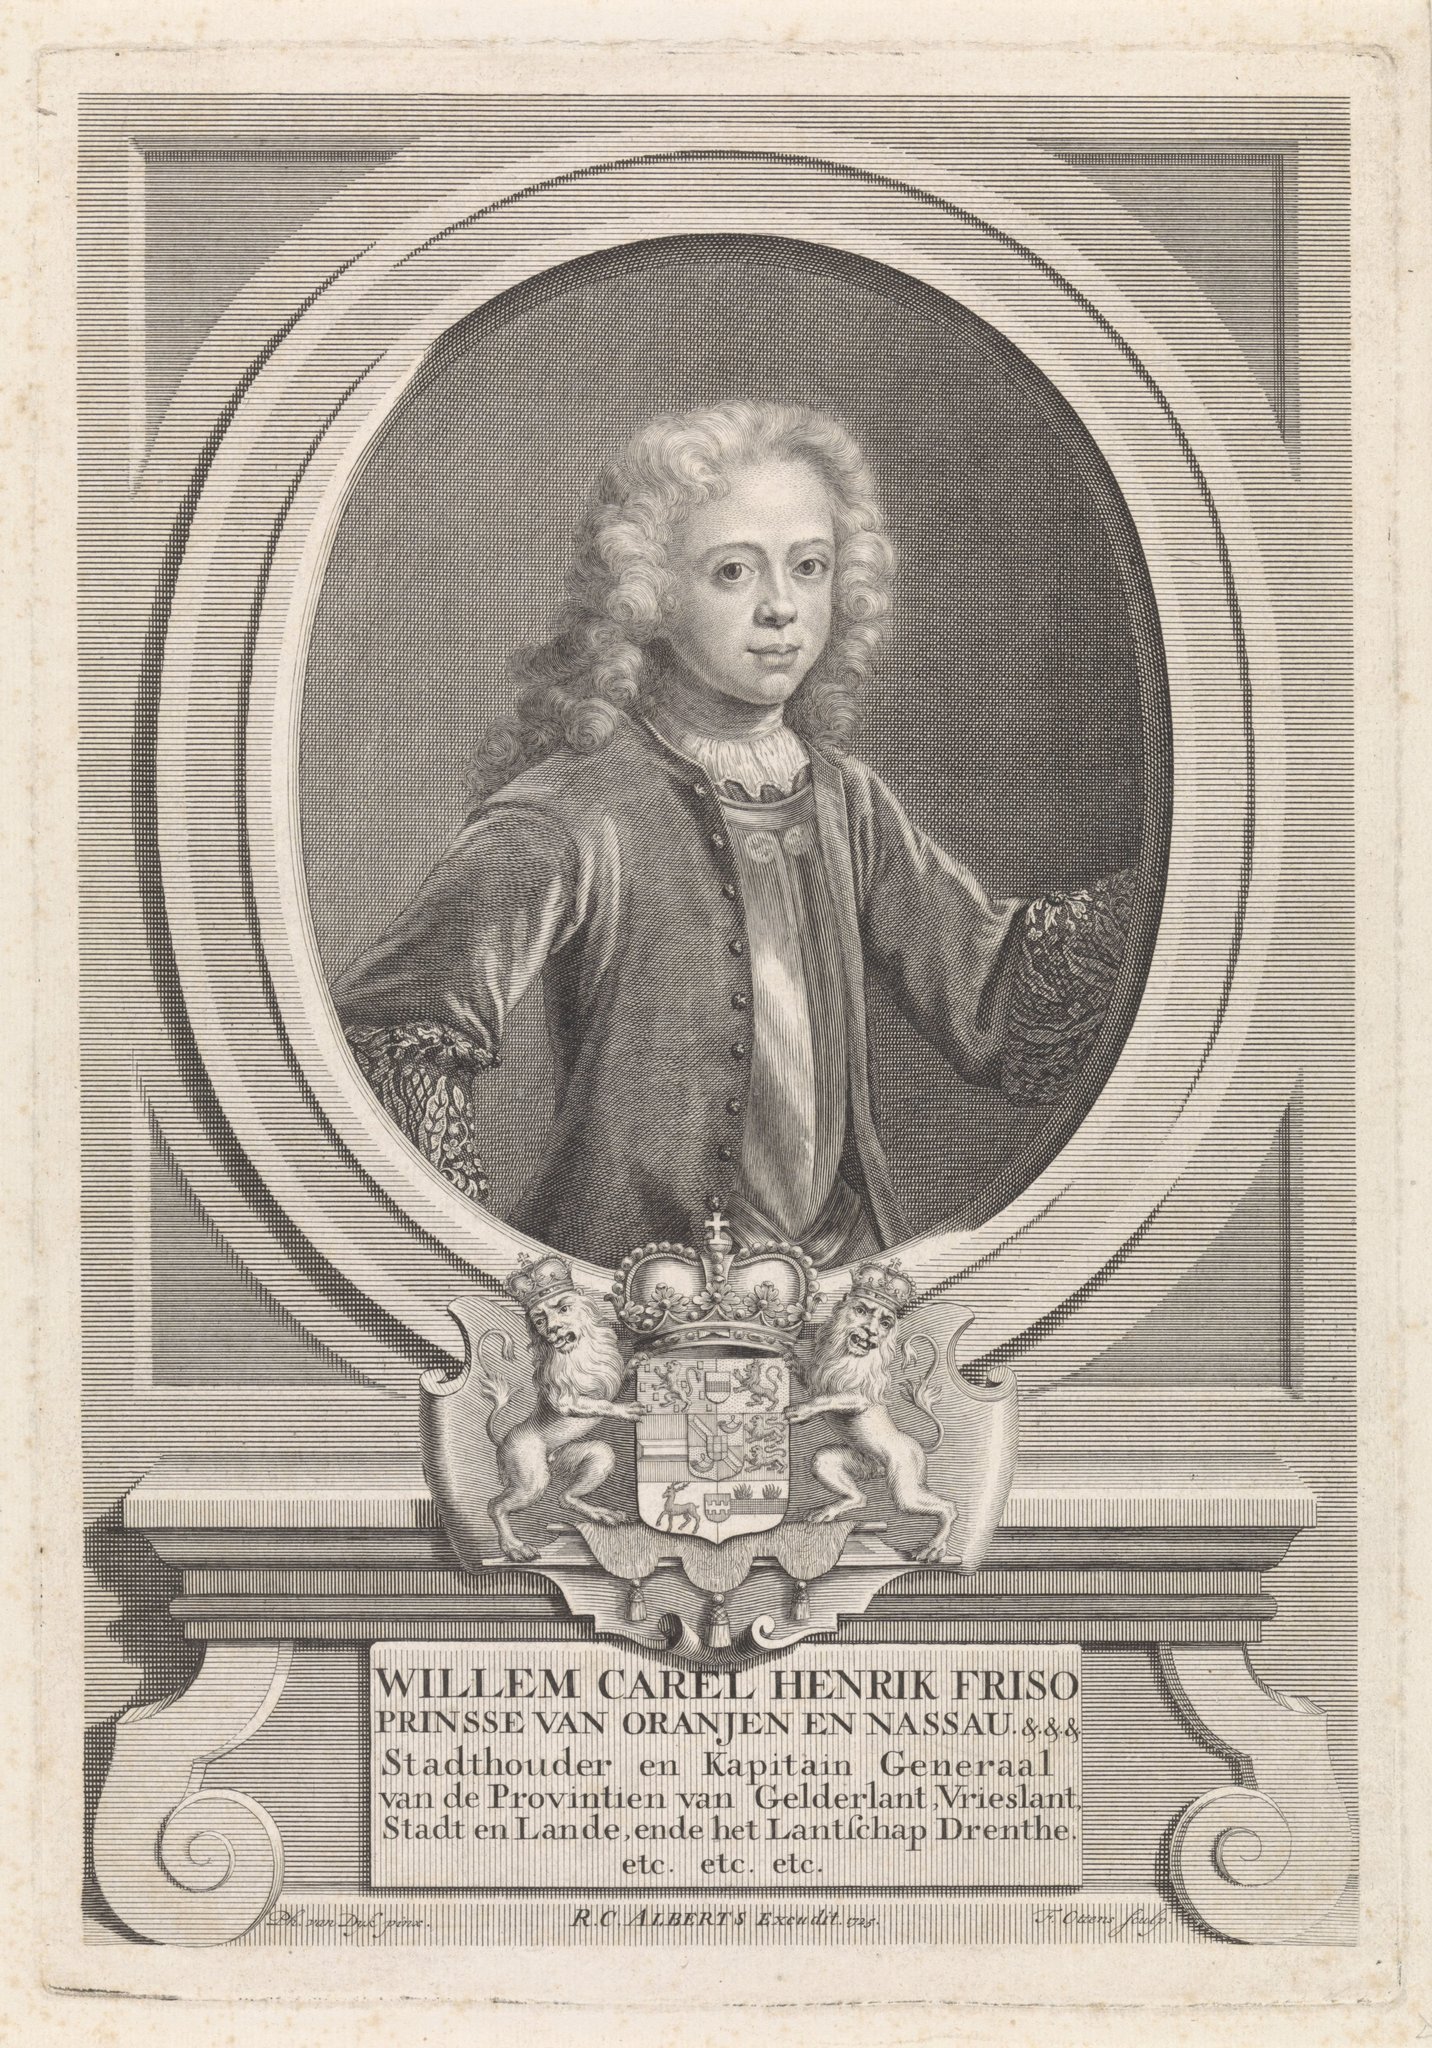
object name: print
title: Portret van Willem IV, prins van Oranje-Nassau als kind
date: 1725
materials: paper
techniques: engraving, etching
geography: the hague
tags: the hague, willem iv (prins van oranje-nassau)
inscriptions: collector's mark: Lugt 2228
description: Portret van Willem IV, prins van Oranje-Nassau op 14-jarige leeftijd. Portret in ovale omlijsting met wapen en cartouche met naam en titels van de geportretteerde.